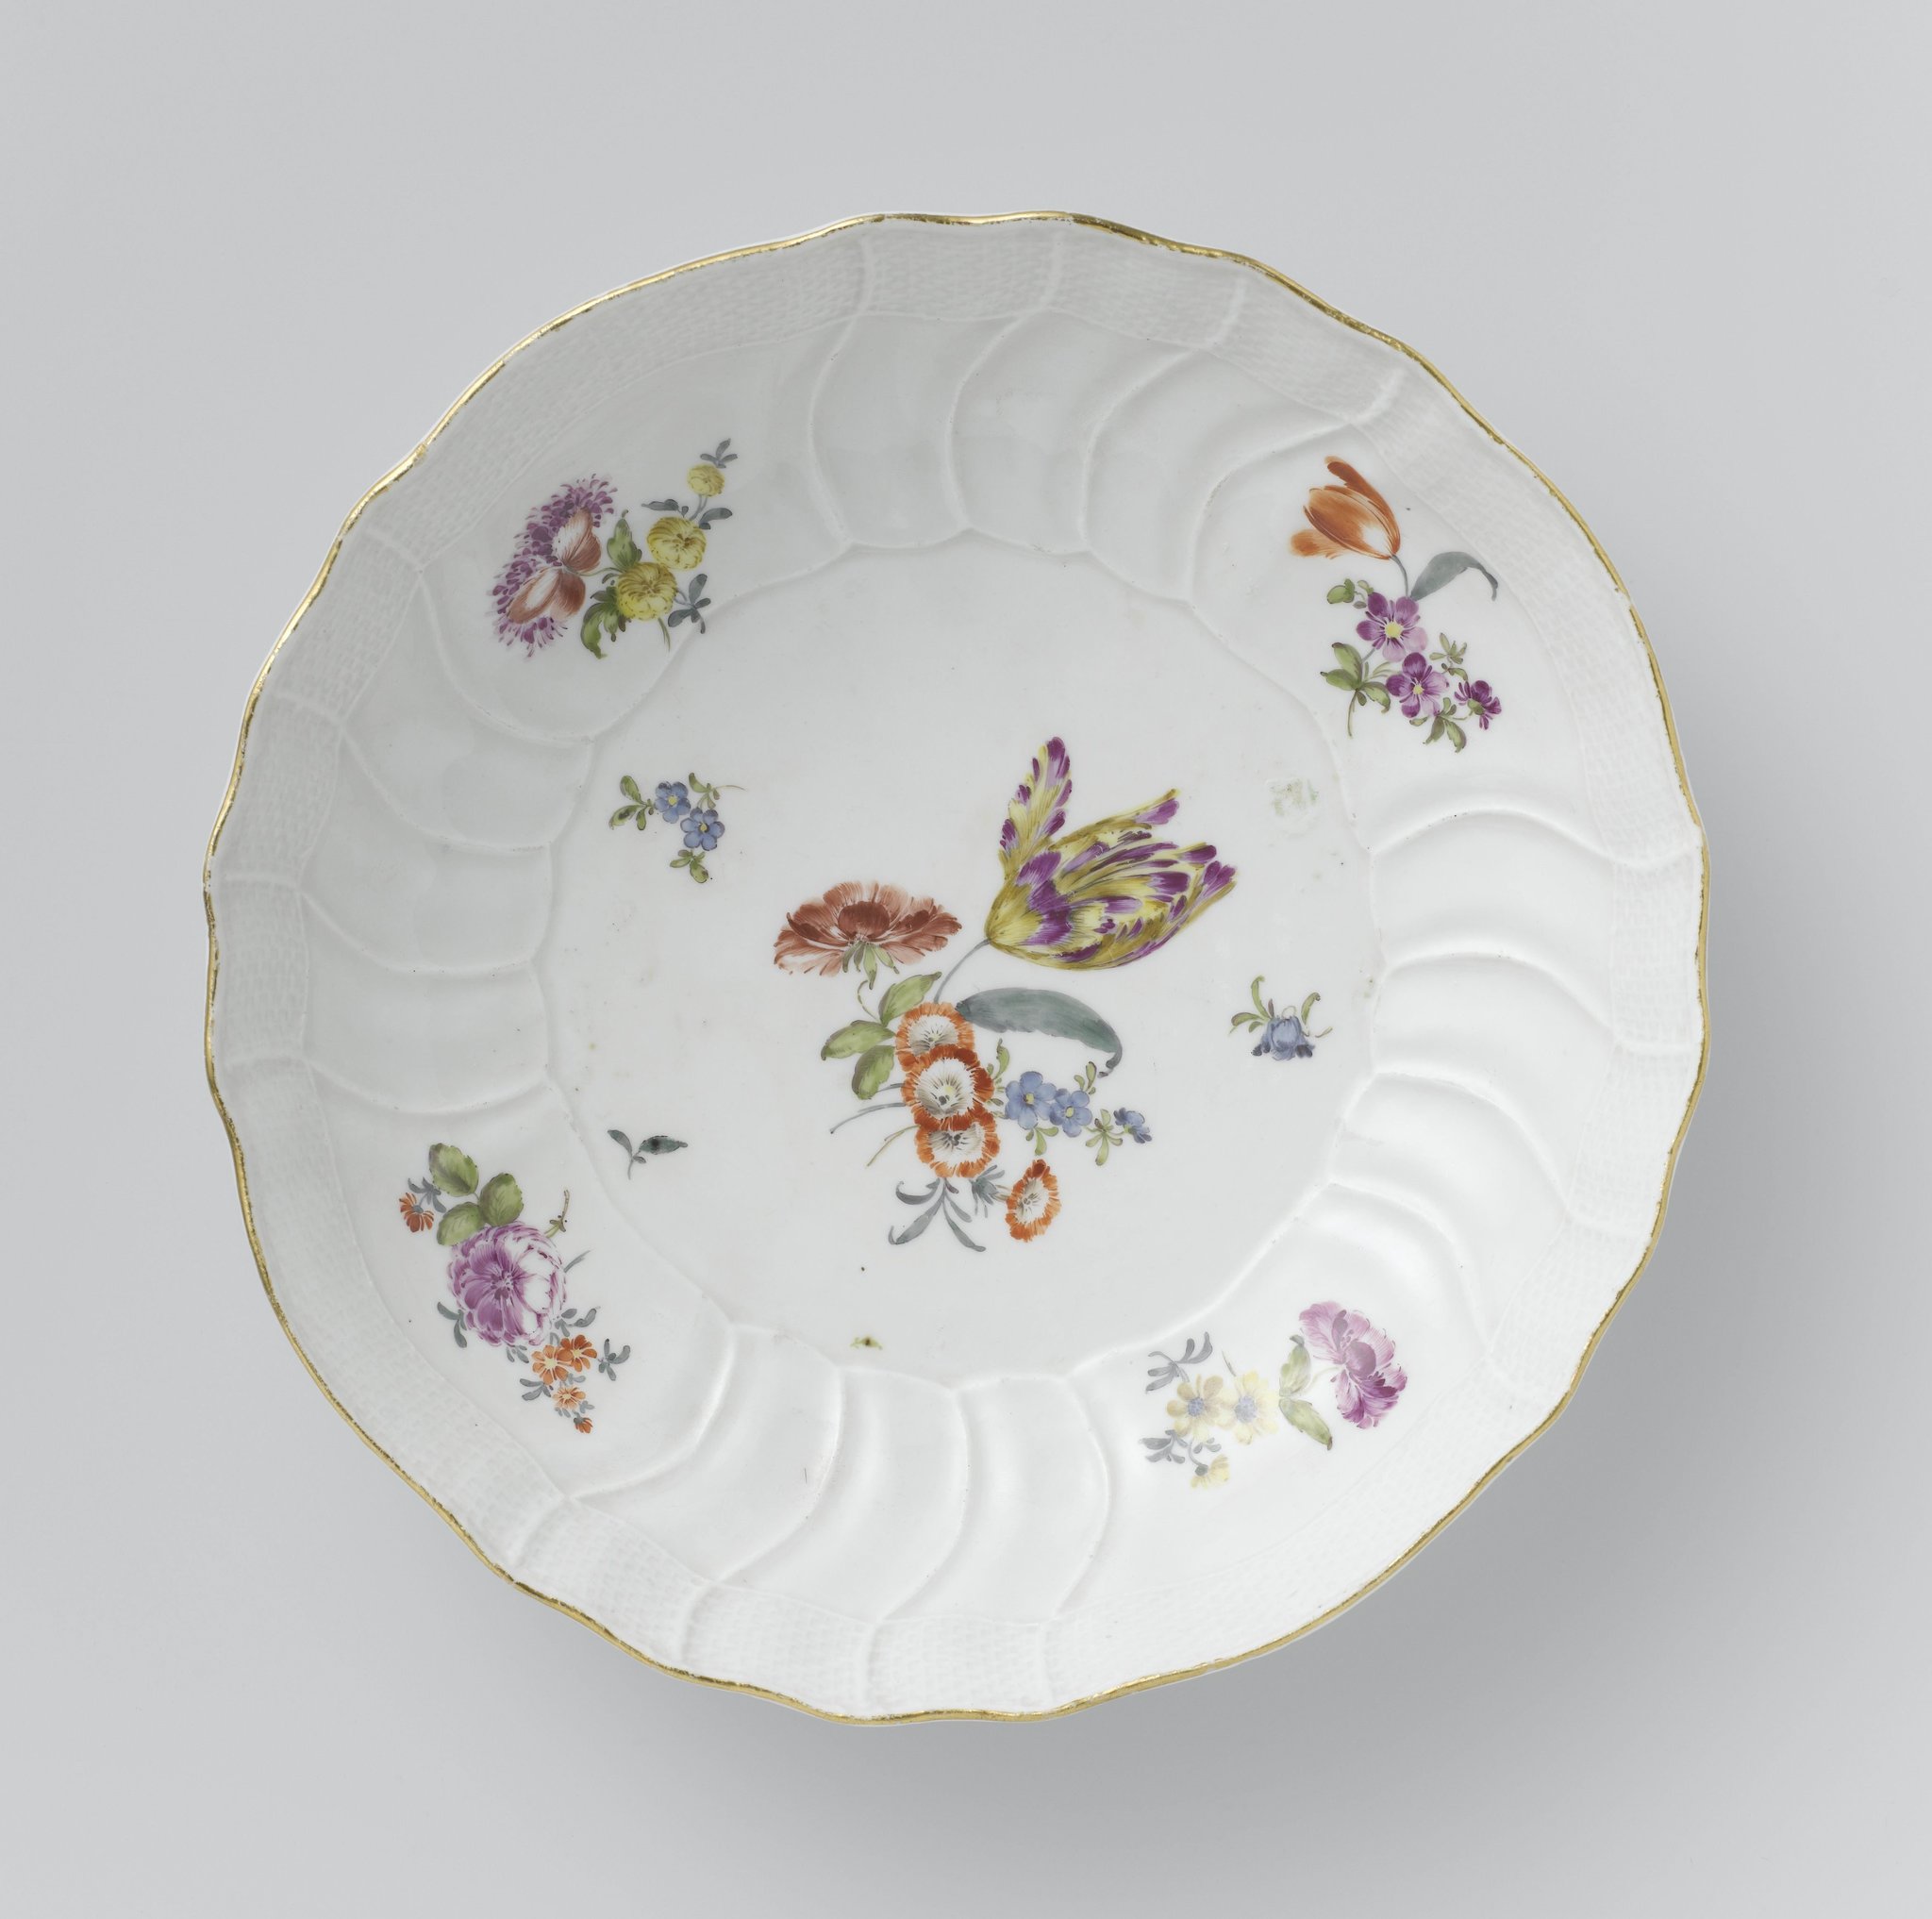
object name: eating drinking utensil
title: Schotel, veelkleurig beschilderd met Deutsche Blumen, insekten en vruchten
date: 1750-1760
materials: porcelain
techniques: painted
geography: meissen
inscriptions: factory mark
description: Ronde schotel van beschilderd porselein. De schotel is beschilderd met Deutsche Blumen, insekten en vruchten. De rand is in reliëf versierd met het Neuozier-patroon. De schotel is gemerkt en hoort bij een servies (BK-17474-1 t/m BK-17474-253).